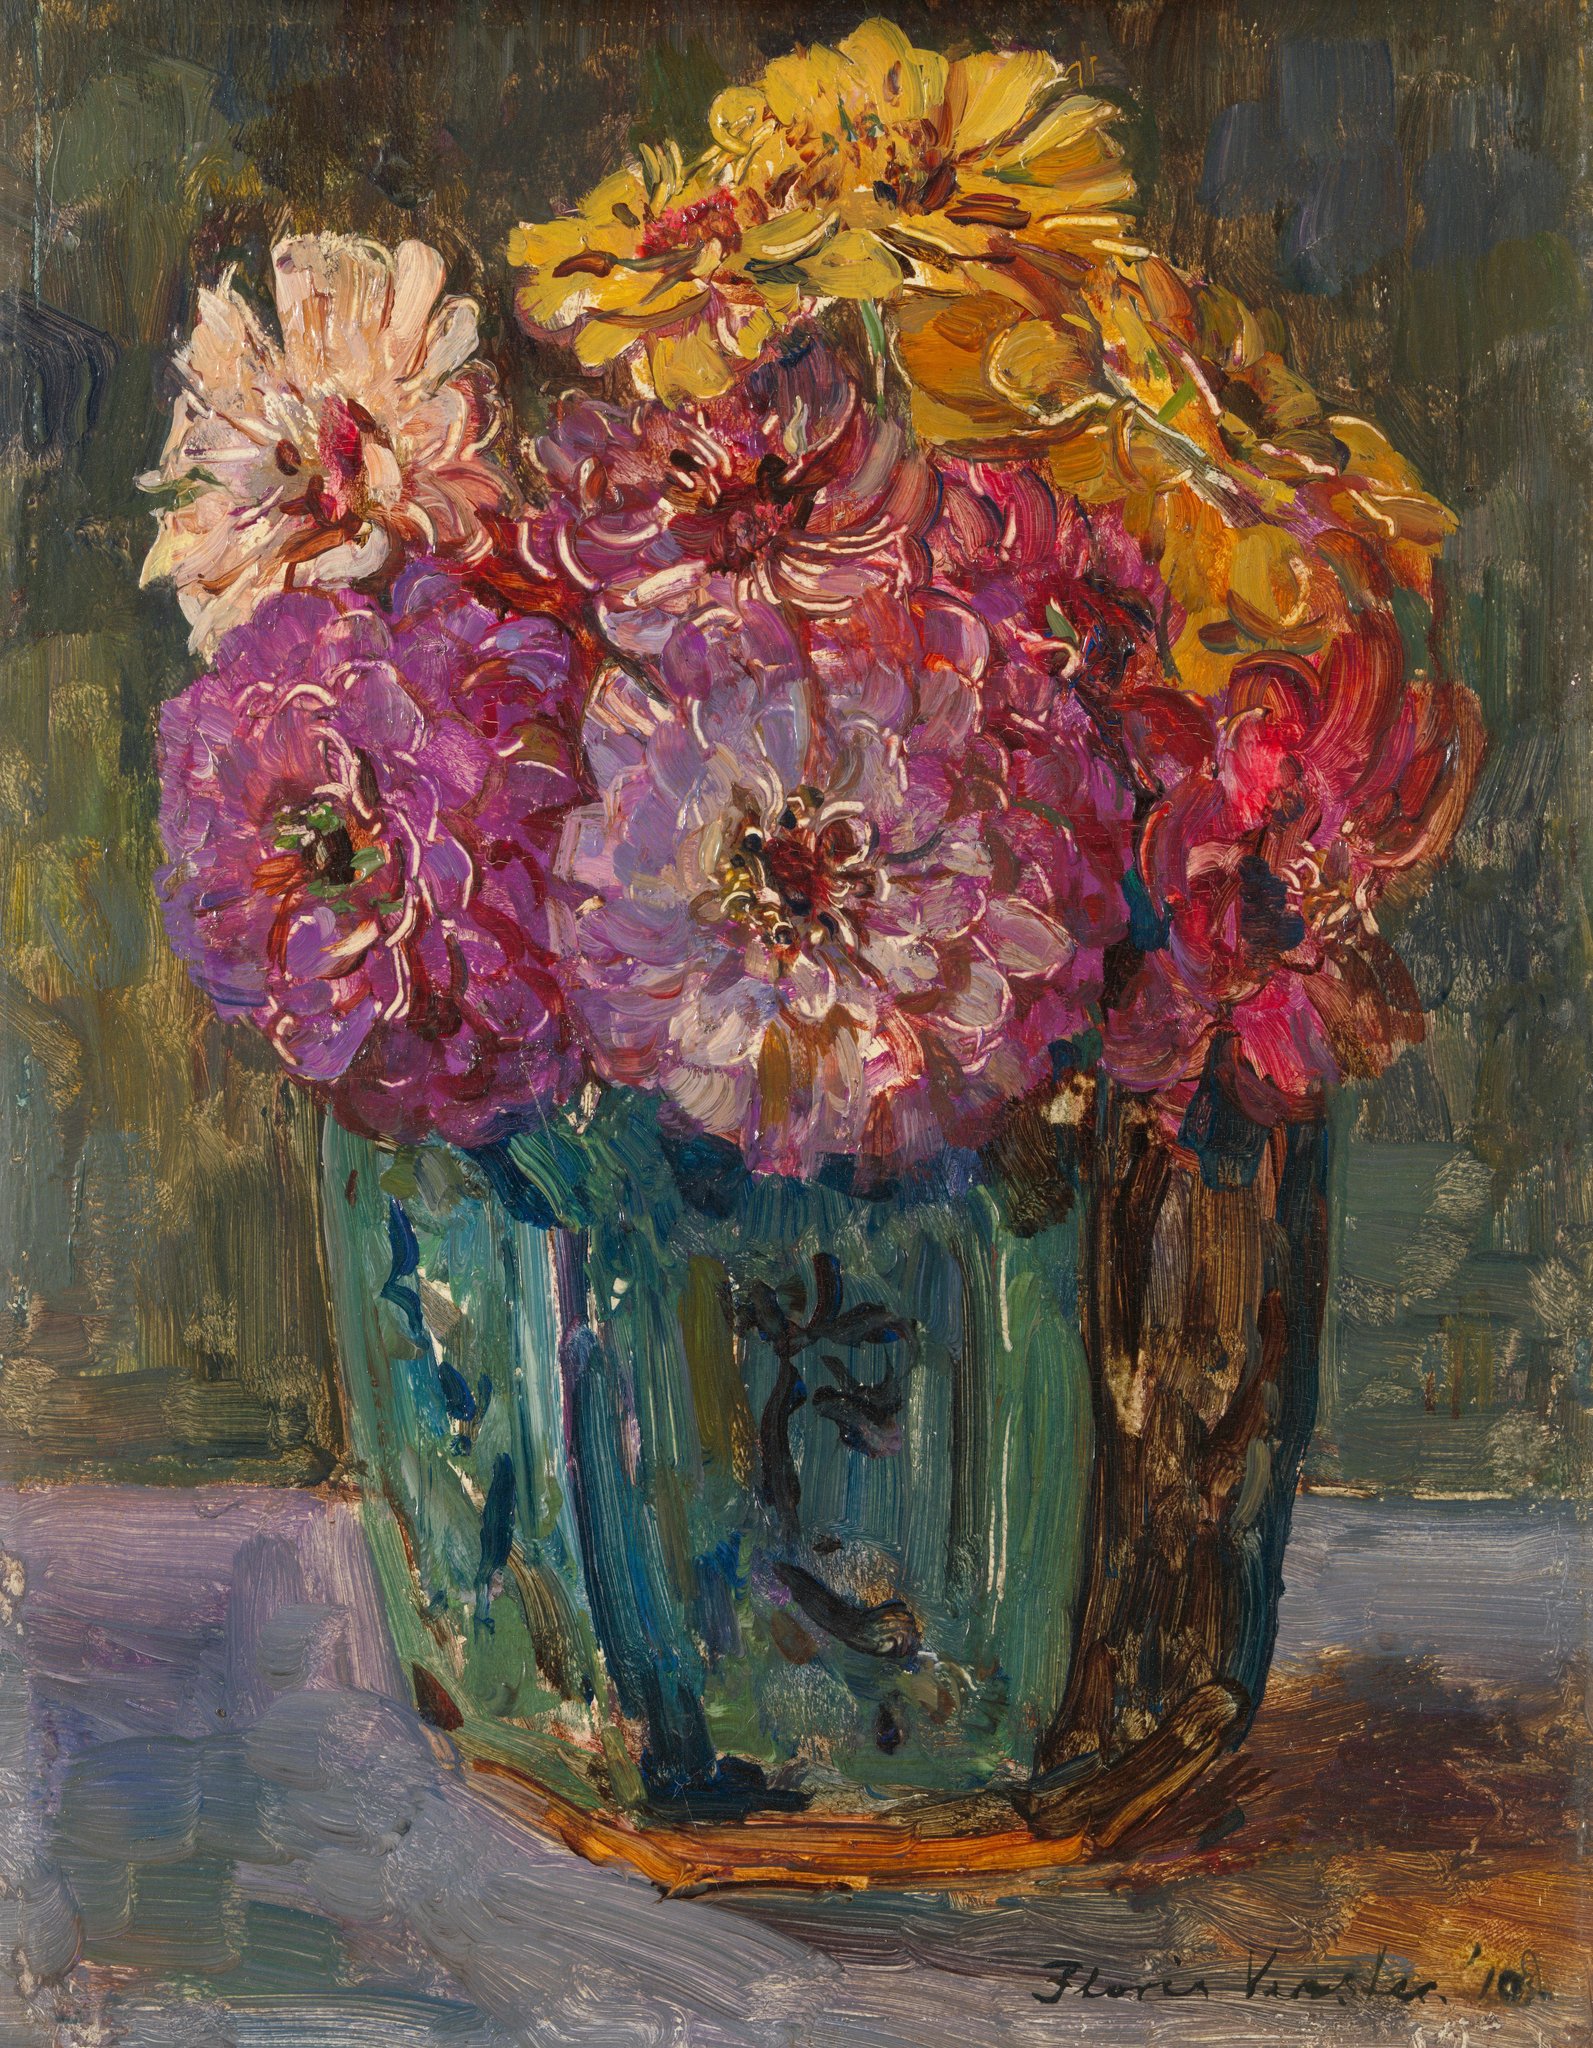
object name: painting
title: Still Life with Zinnias in a green Jar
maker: floris verster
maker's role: draughtsman, painter, print maker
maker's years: 1861-1927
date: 1910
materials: oil, panel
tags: flowers, flowers in a vase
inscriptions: signature and date: ‘Floris Verster '10’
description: Stilleven met bloemen: paarse en groene zinnia's in een groene gemberpot.